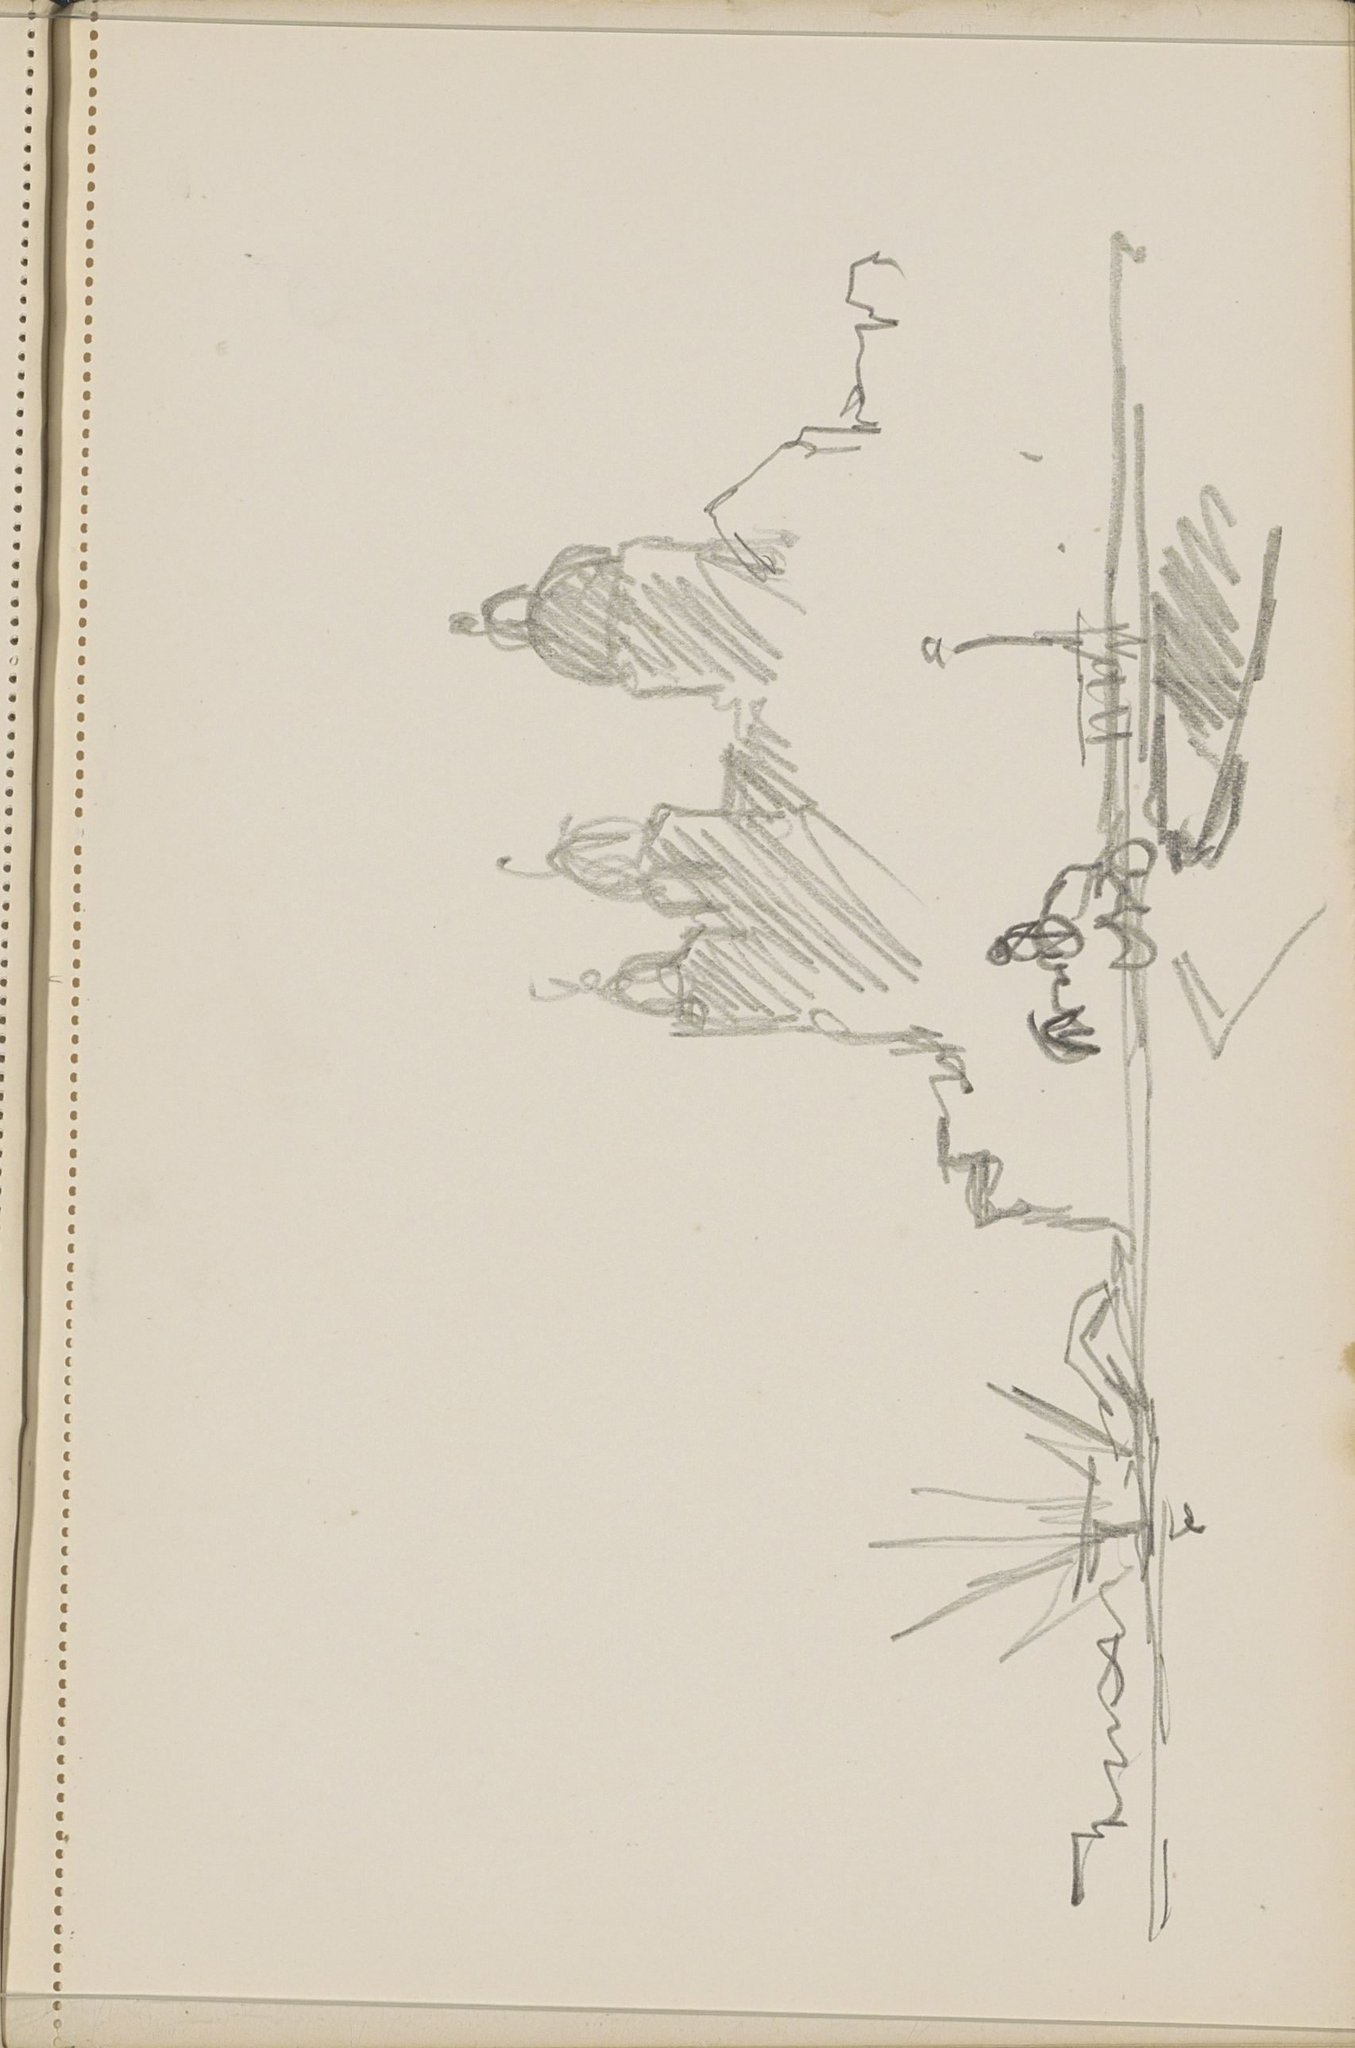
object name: sketchbook leaf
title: Gebouw met drie torens aan een weg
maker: cornelis vreedenburgh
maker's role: draughtsman, print maker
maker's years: 1880-1946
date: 1890-1946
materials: paper, pencil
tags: tower (of house or building)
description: Blad 51 recto uit een schetsboek met 59 bladen.